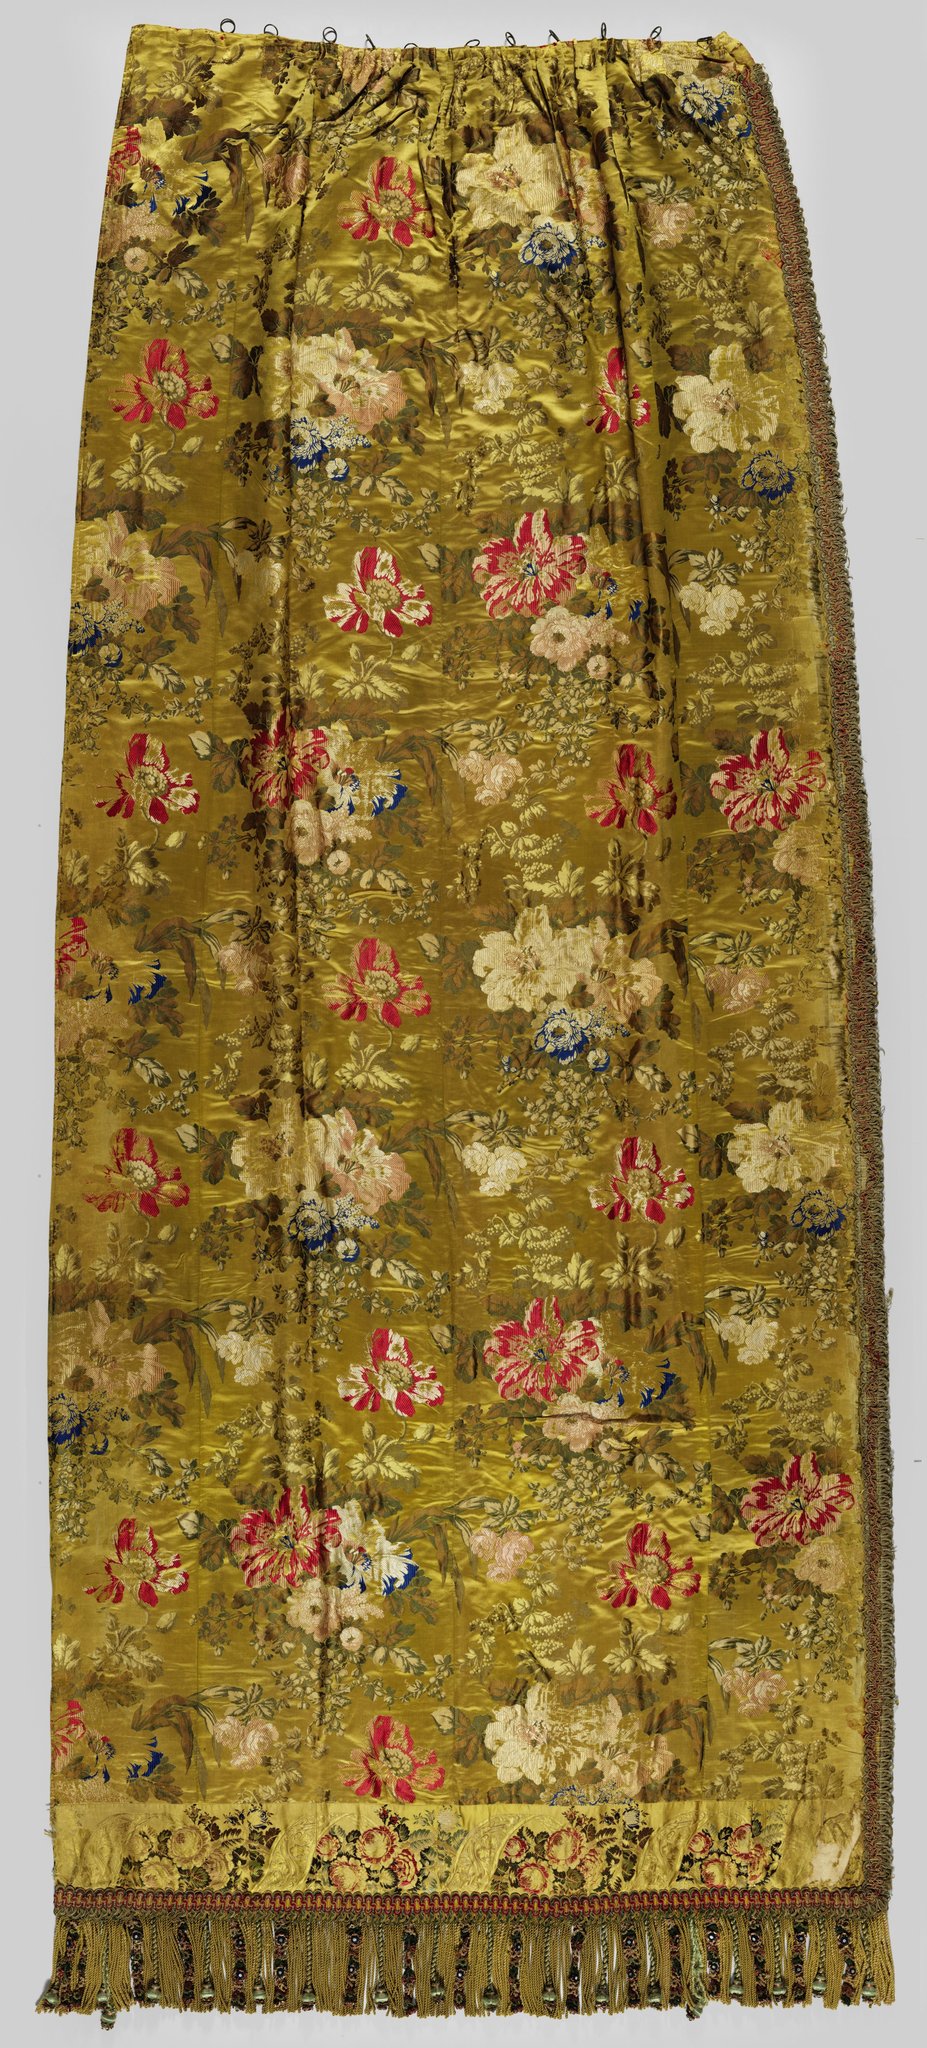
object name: curtain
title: Gordijn, met bloemdessin op geel fond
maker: carel hubertus windt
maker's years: 1804-1860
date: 1850-1860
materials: silk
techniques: lampas, weave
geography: lyon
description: Gordijn van zijde met bloemdessin op geel fond, afkomstig uit de kleine danszaal van Paleis Noordeinde.